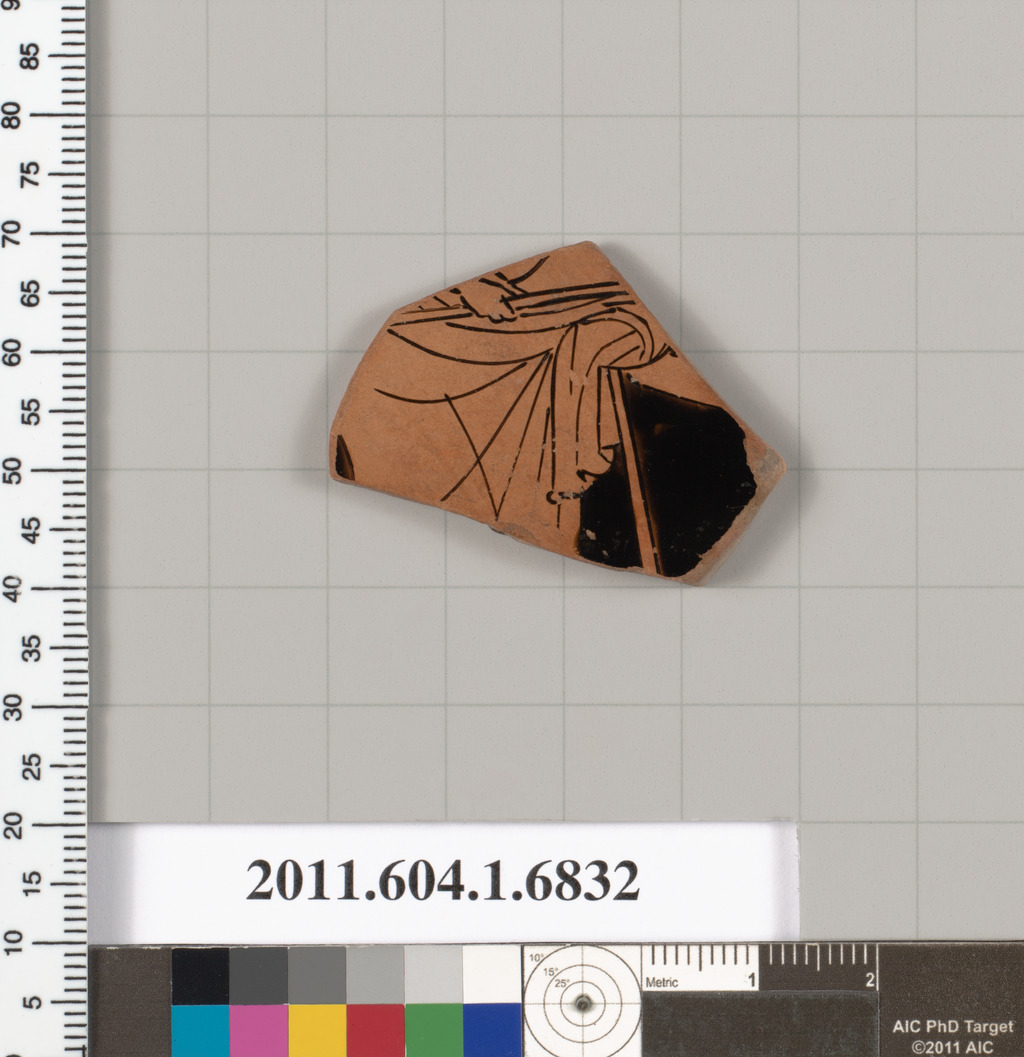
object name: kylix fragment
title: Terracotta fragment of a kylix (drinking cup)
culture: greek, attic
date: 490-470 BCE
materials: terracotta